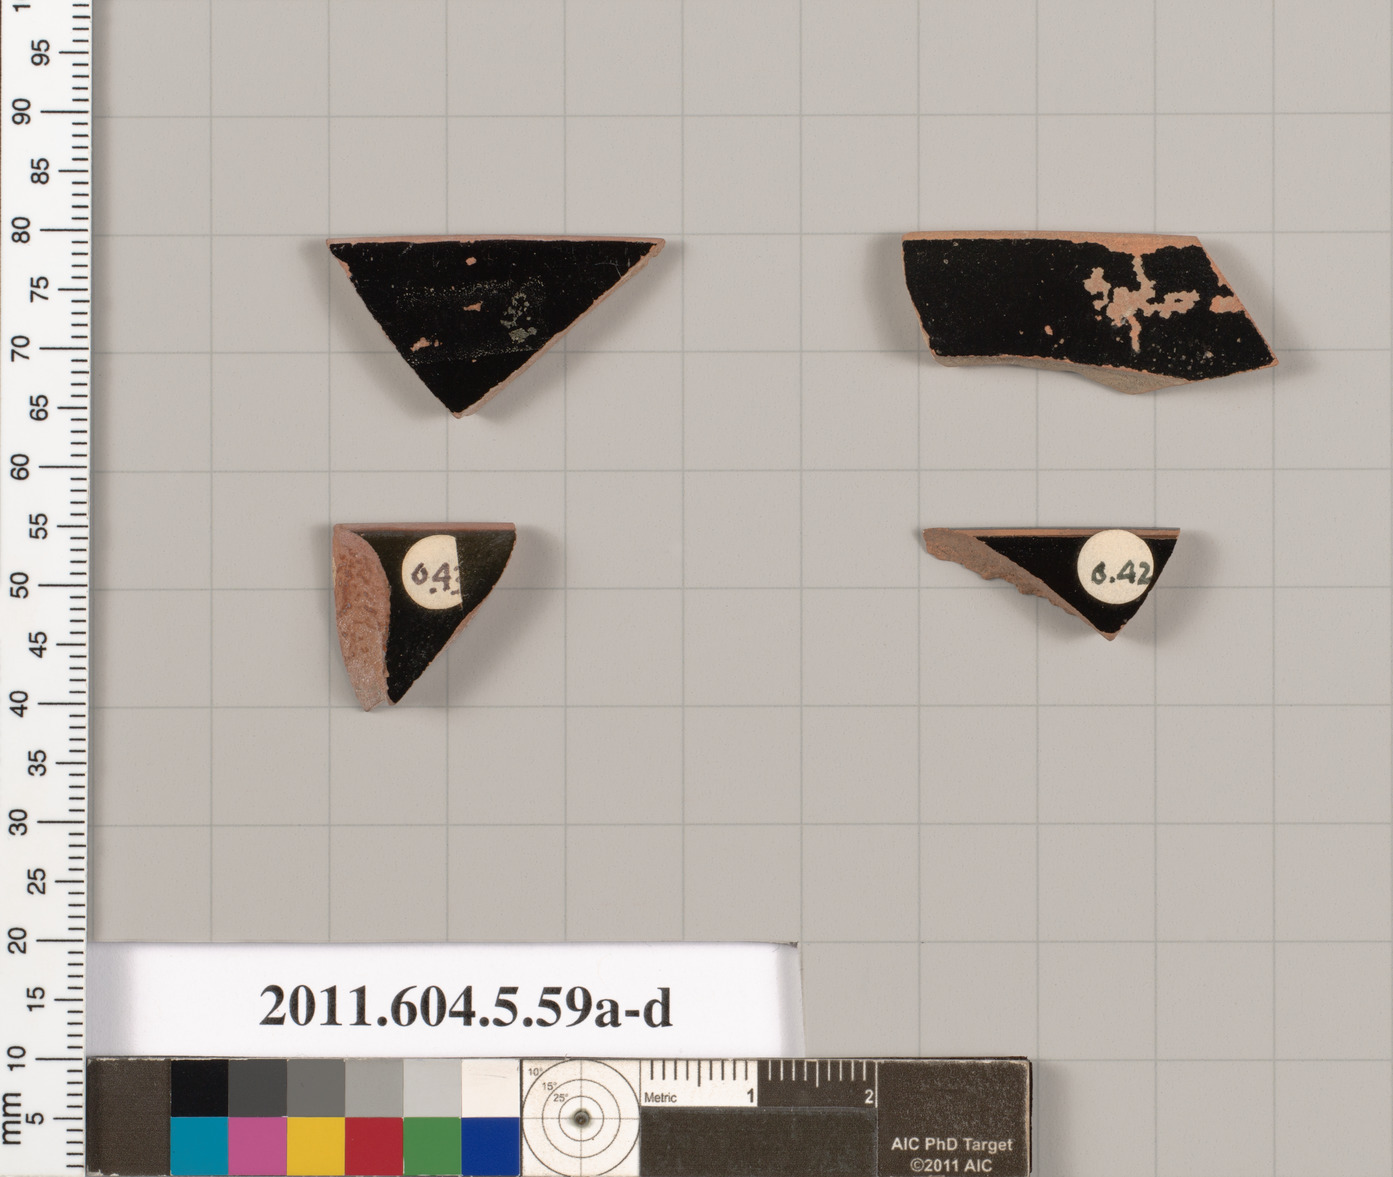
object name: kylix fragment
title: Terracotta rim fragments of kylikes (drinking cups)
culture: greek, attic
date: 500-401 BCE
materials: terracotta